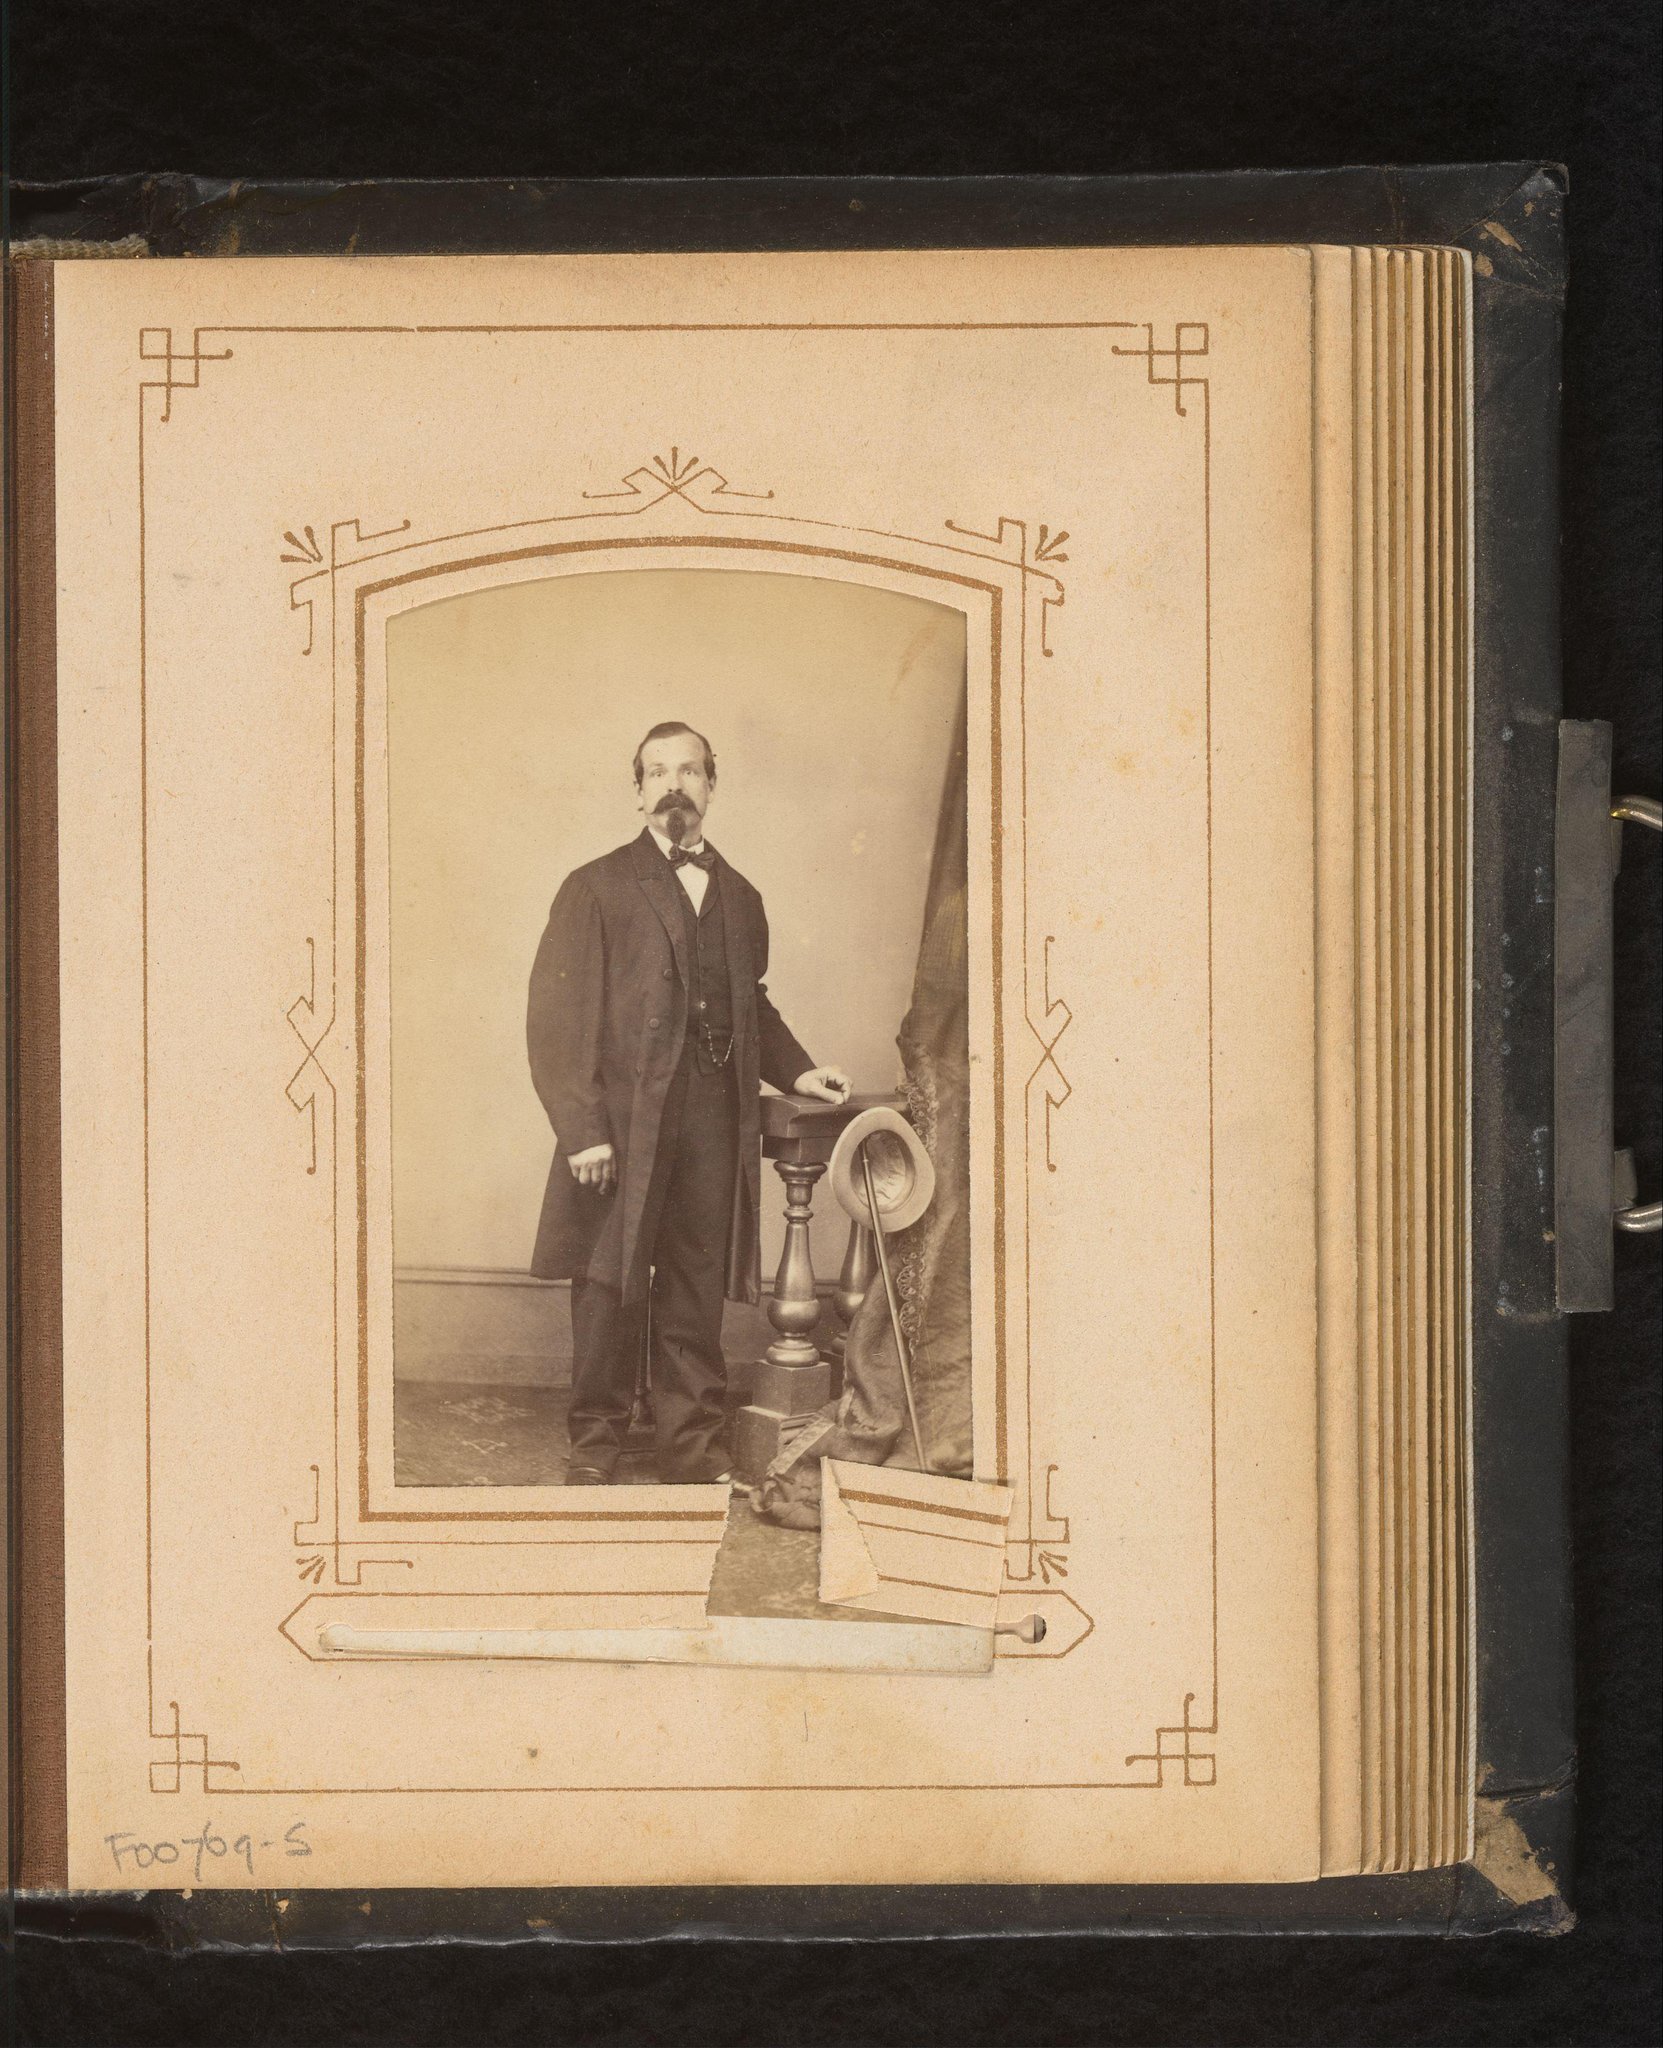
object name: photograph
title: Portret van een staande man met snor en sik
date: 1865-1900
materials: cardboard, photographic support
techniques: albumen print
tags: moustache, adult man, historical persons, head-gear: hat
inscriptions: number: ‘1493’, inscription: ‘Photographed by/ R & C Steinebach/ S.E. cor. Sixth and Callowhill Sts./ Philadelphia/ No. [...]’